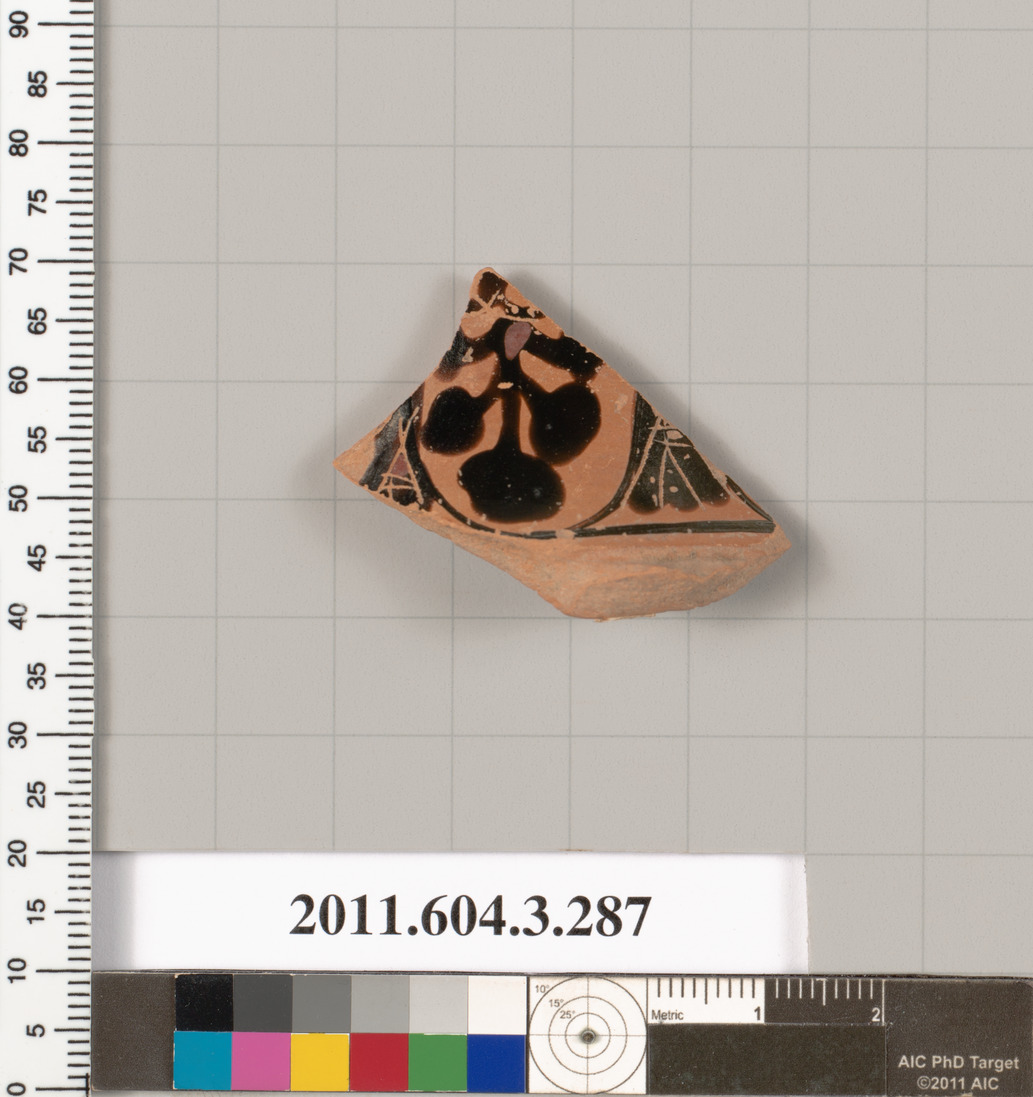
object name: neck amphora fragment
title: Terracotta fragment of a neck-amphora (jar)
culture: greek, attic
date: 530-520 BCE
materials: terracotta